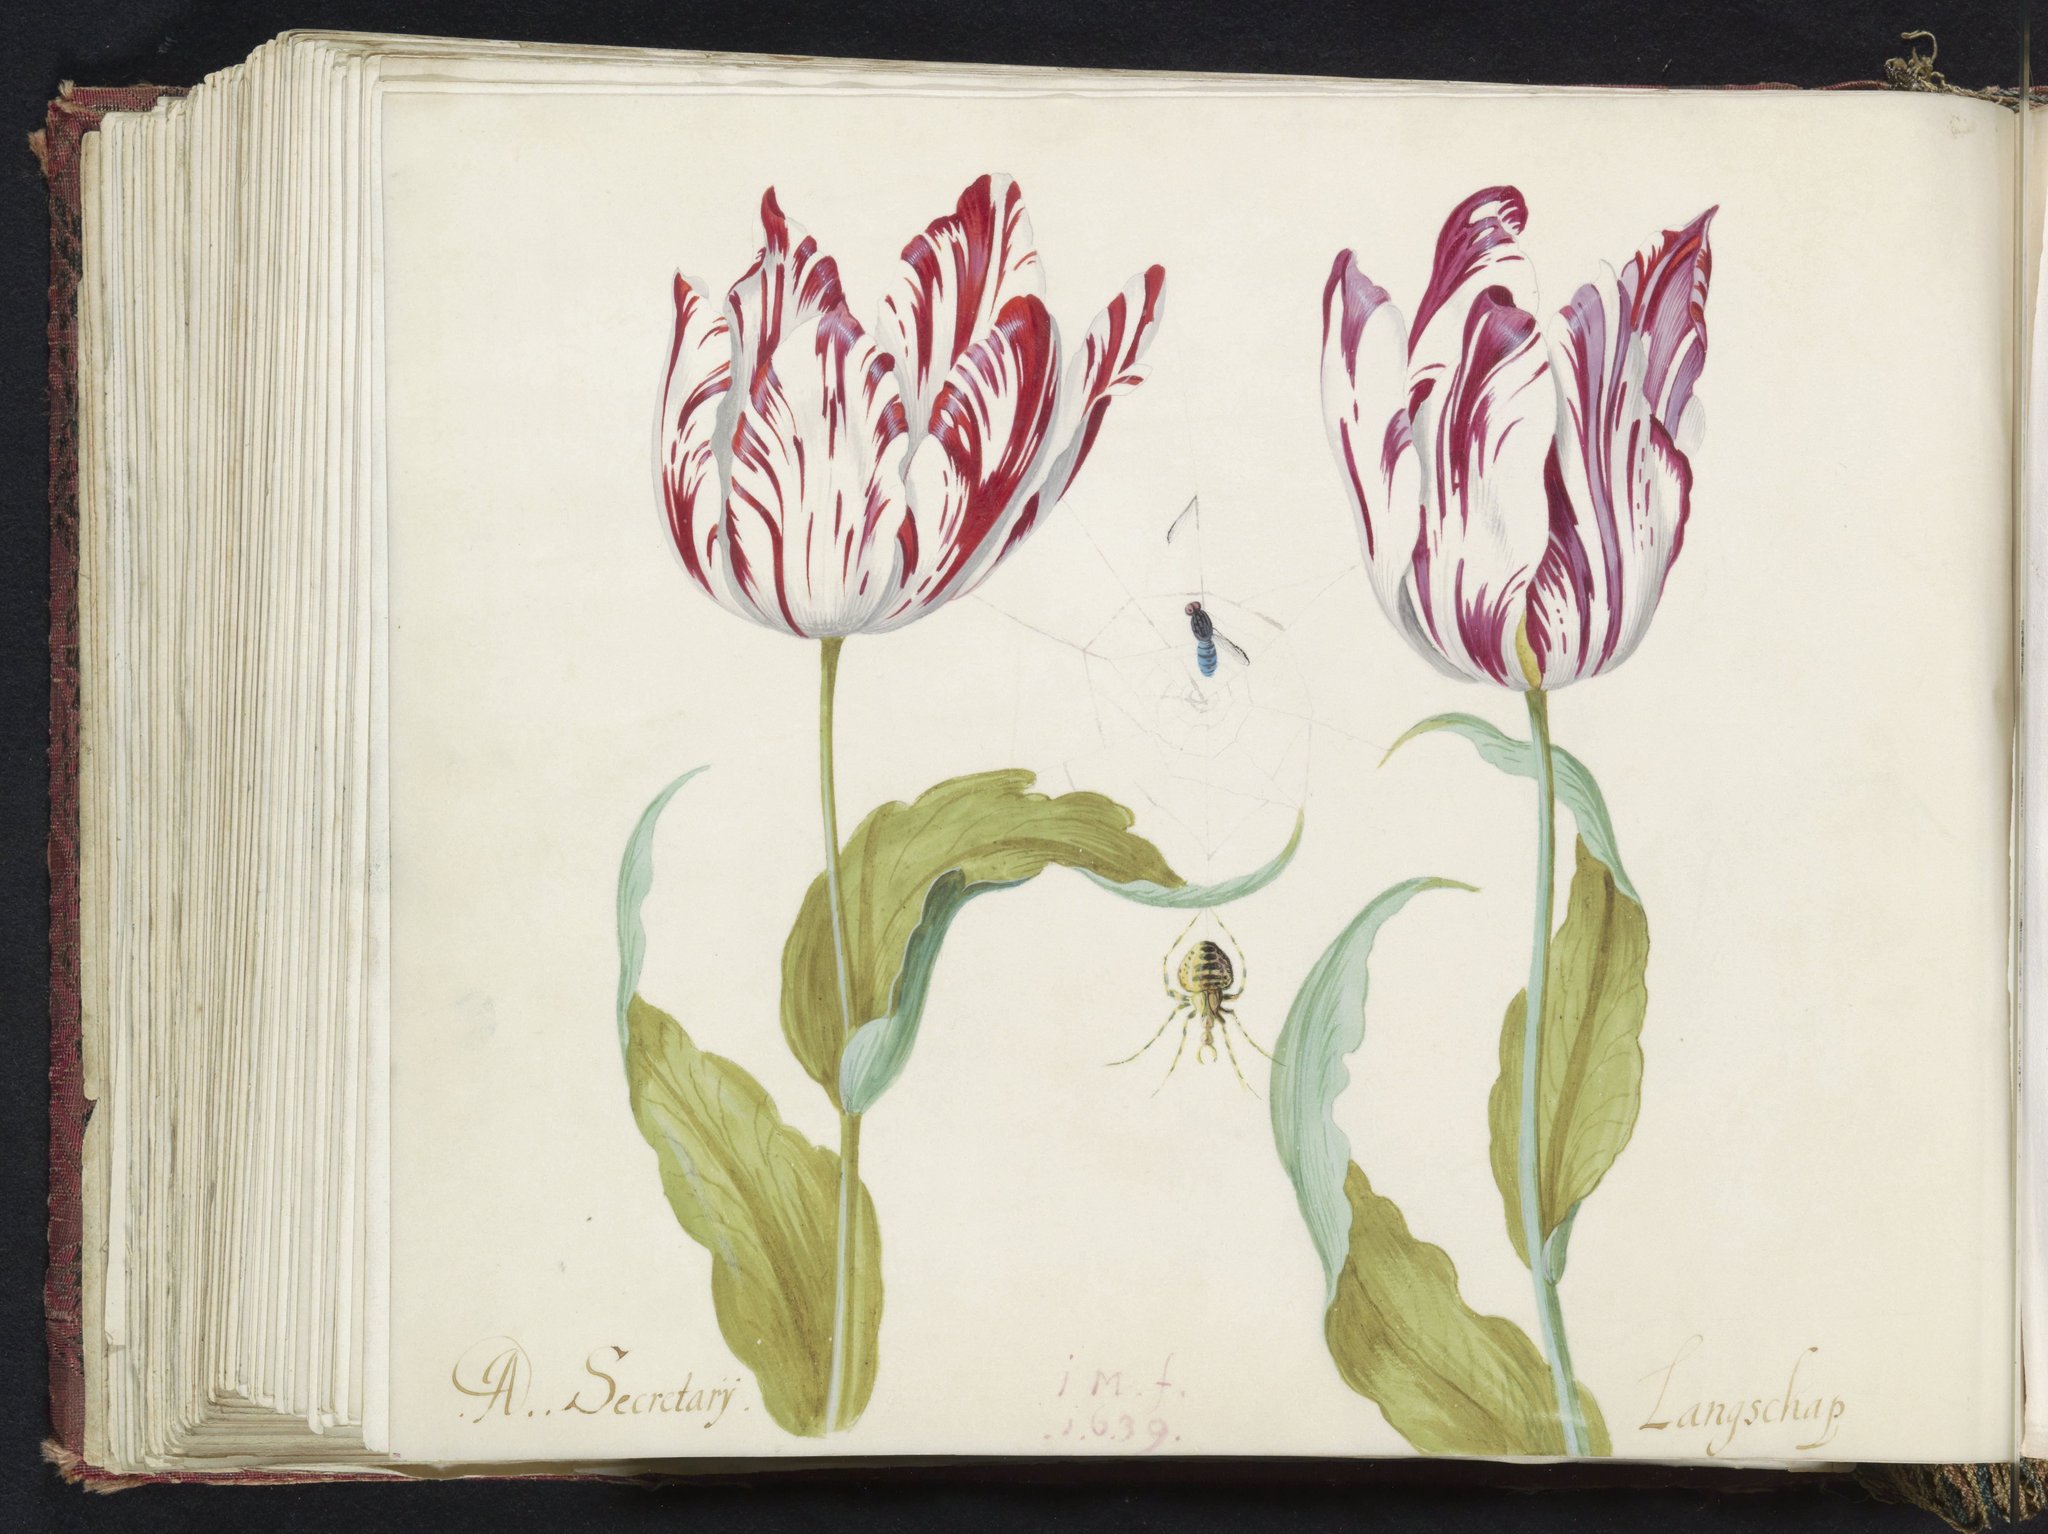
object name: album leaf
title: A. Secretarij / Langschap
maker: jacob marrel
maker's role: draughtsman, painter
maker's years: 1614-1681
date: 1639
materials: paint, parchment, pencil, watercolor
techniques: brush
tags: spiders, flowers: tulip, insects: fly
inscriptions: date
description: De tekening maakt deel uit van een album.